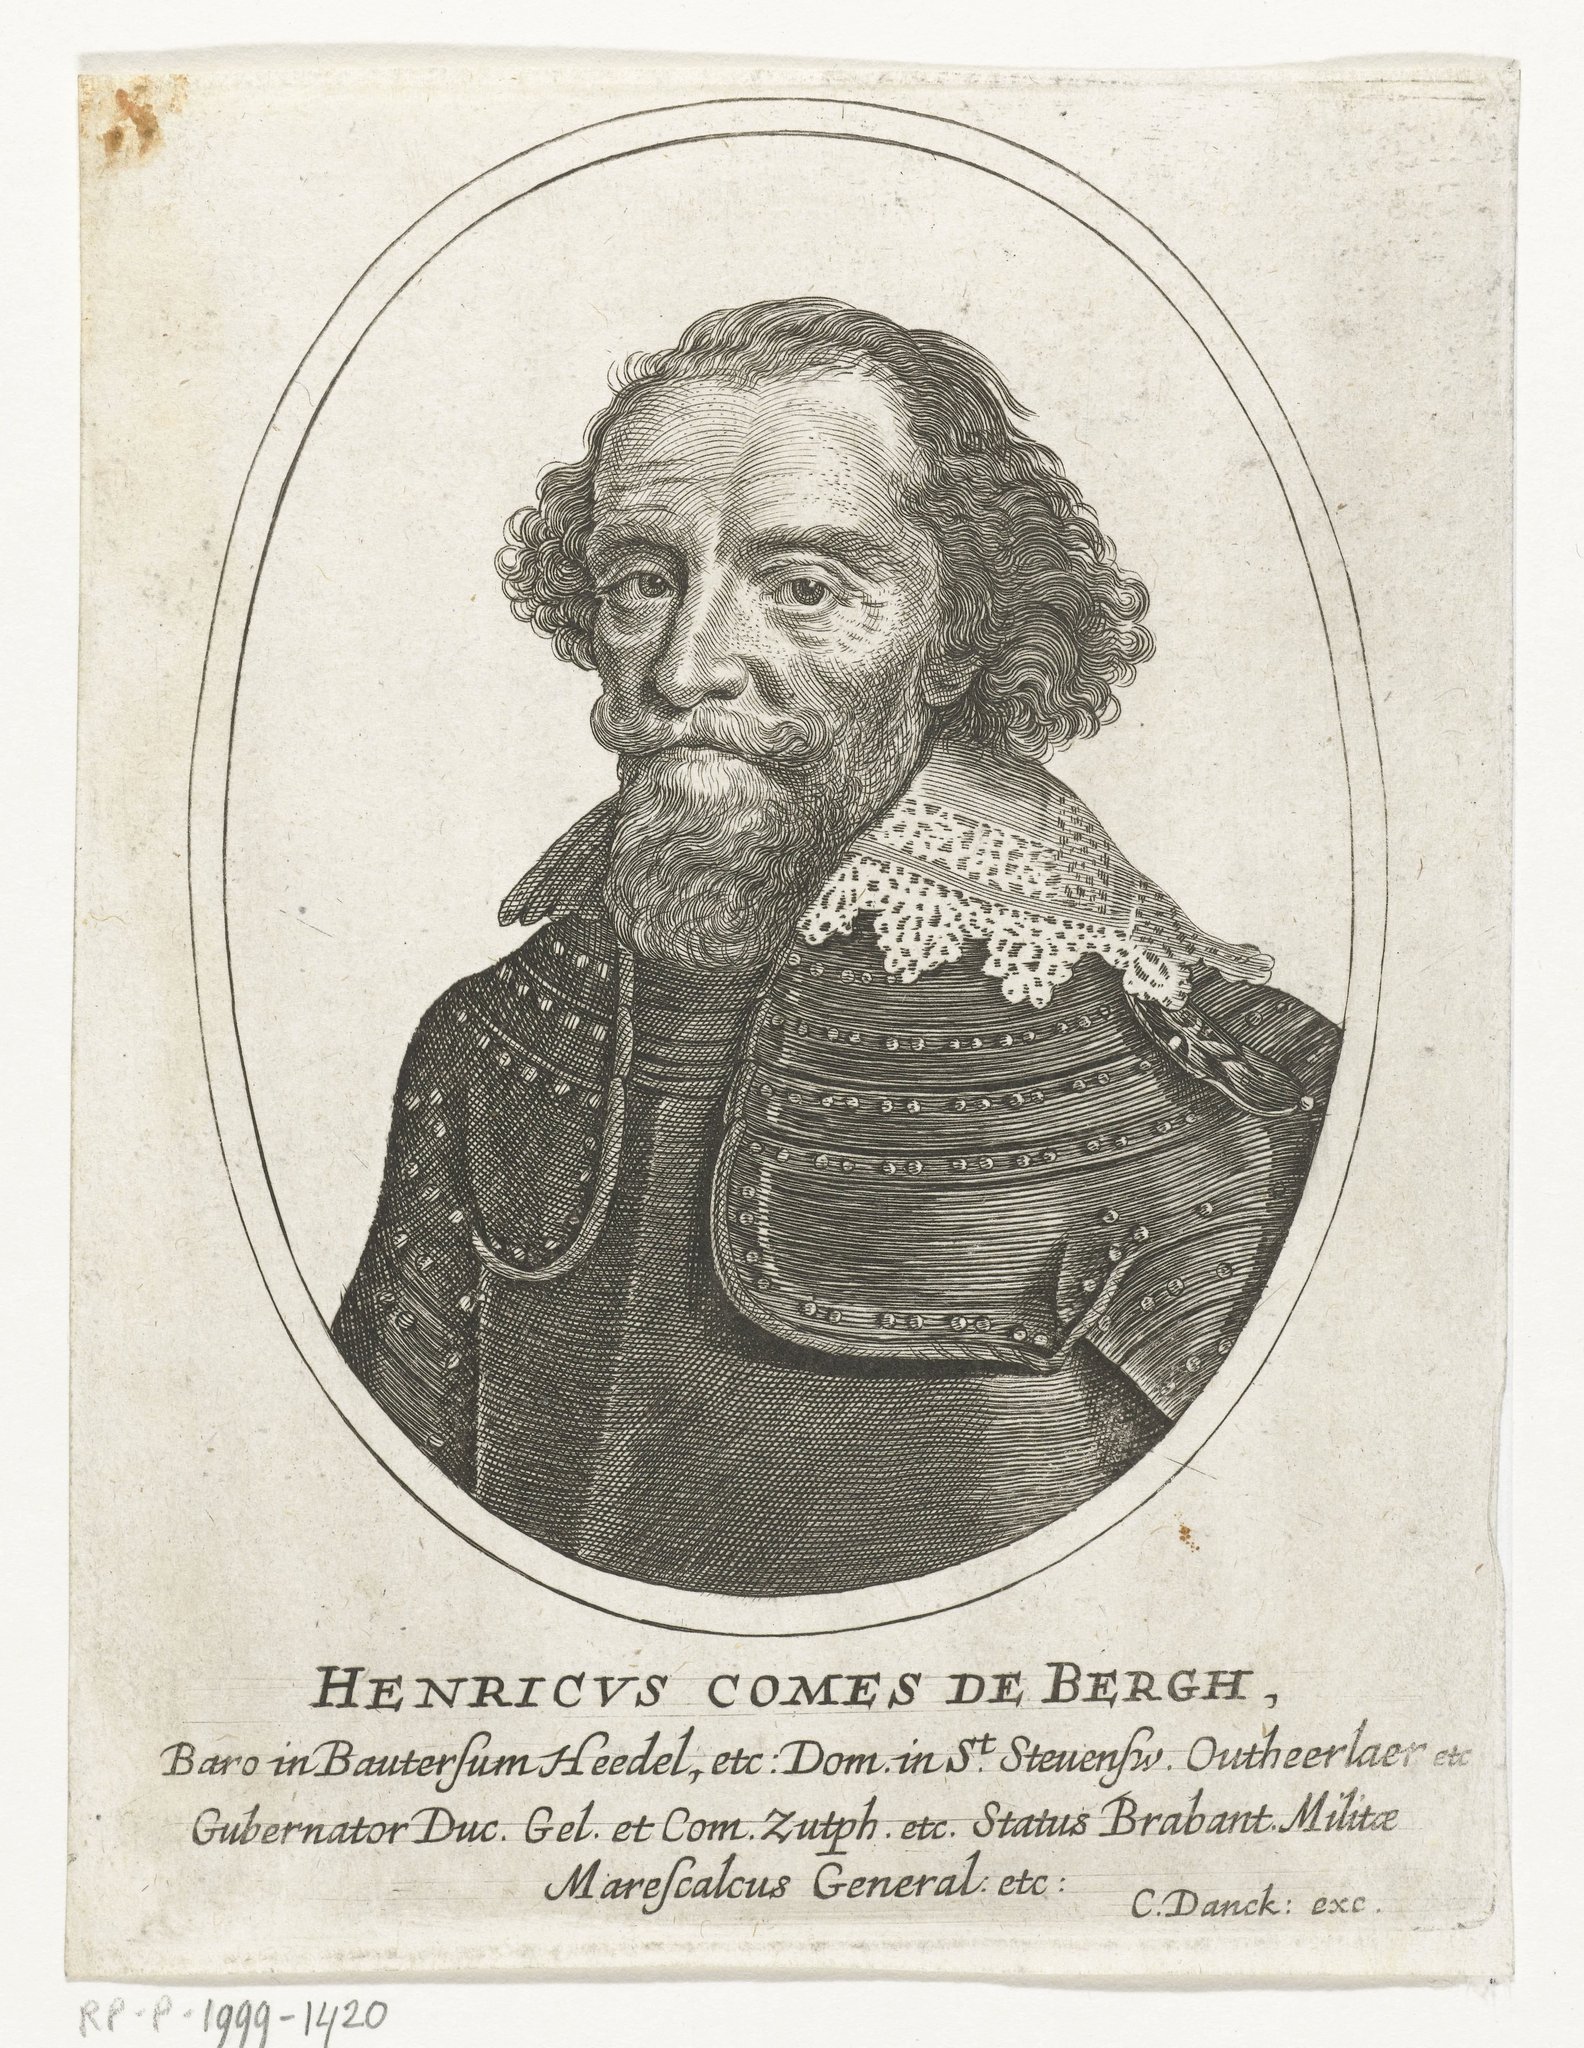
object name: print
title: Henricvs Comes de Bergh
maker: cornelis danckerts (i)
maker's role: print maker, publisher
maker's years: 1604-1656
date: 1613-1656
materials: paper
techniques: engraving, etching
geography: netherlands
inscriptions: collector's mark: Lugt 2228, collector's mark: Lugt 2760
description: Portret van Hendrik, graaf van Bergh, borststuk gekleed in harnas in ovaal.